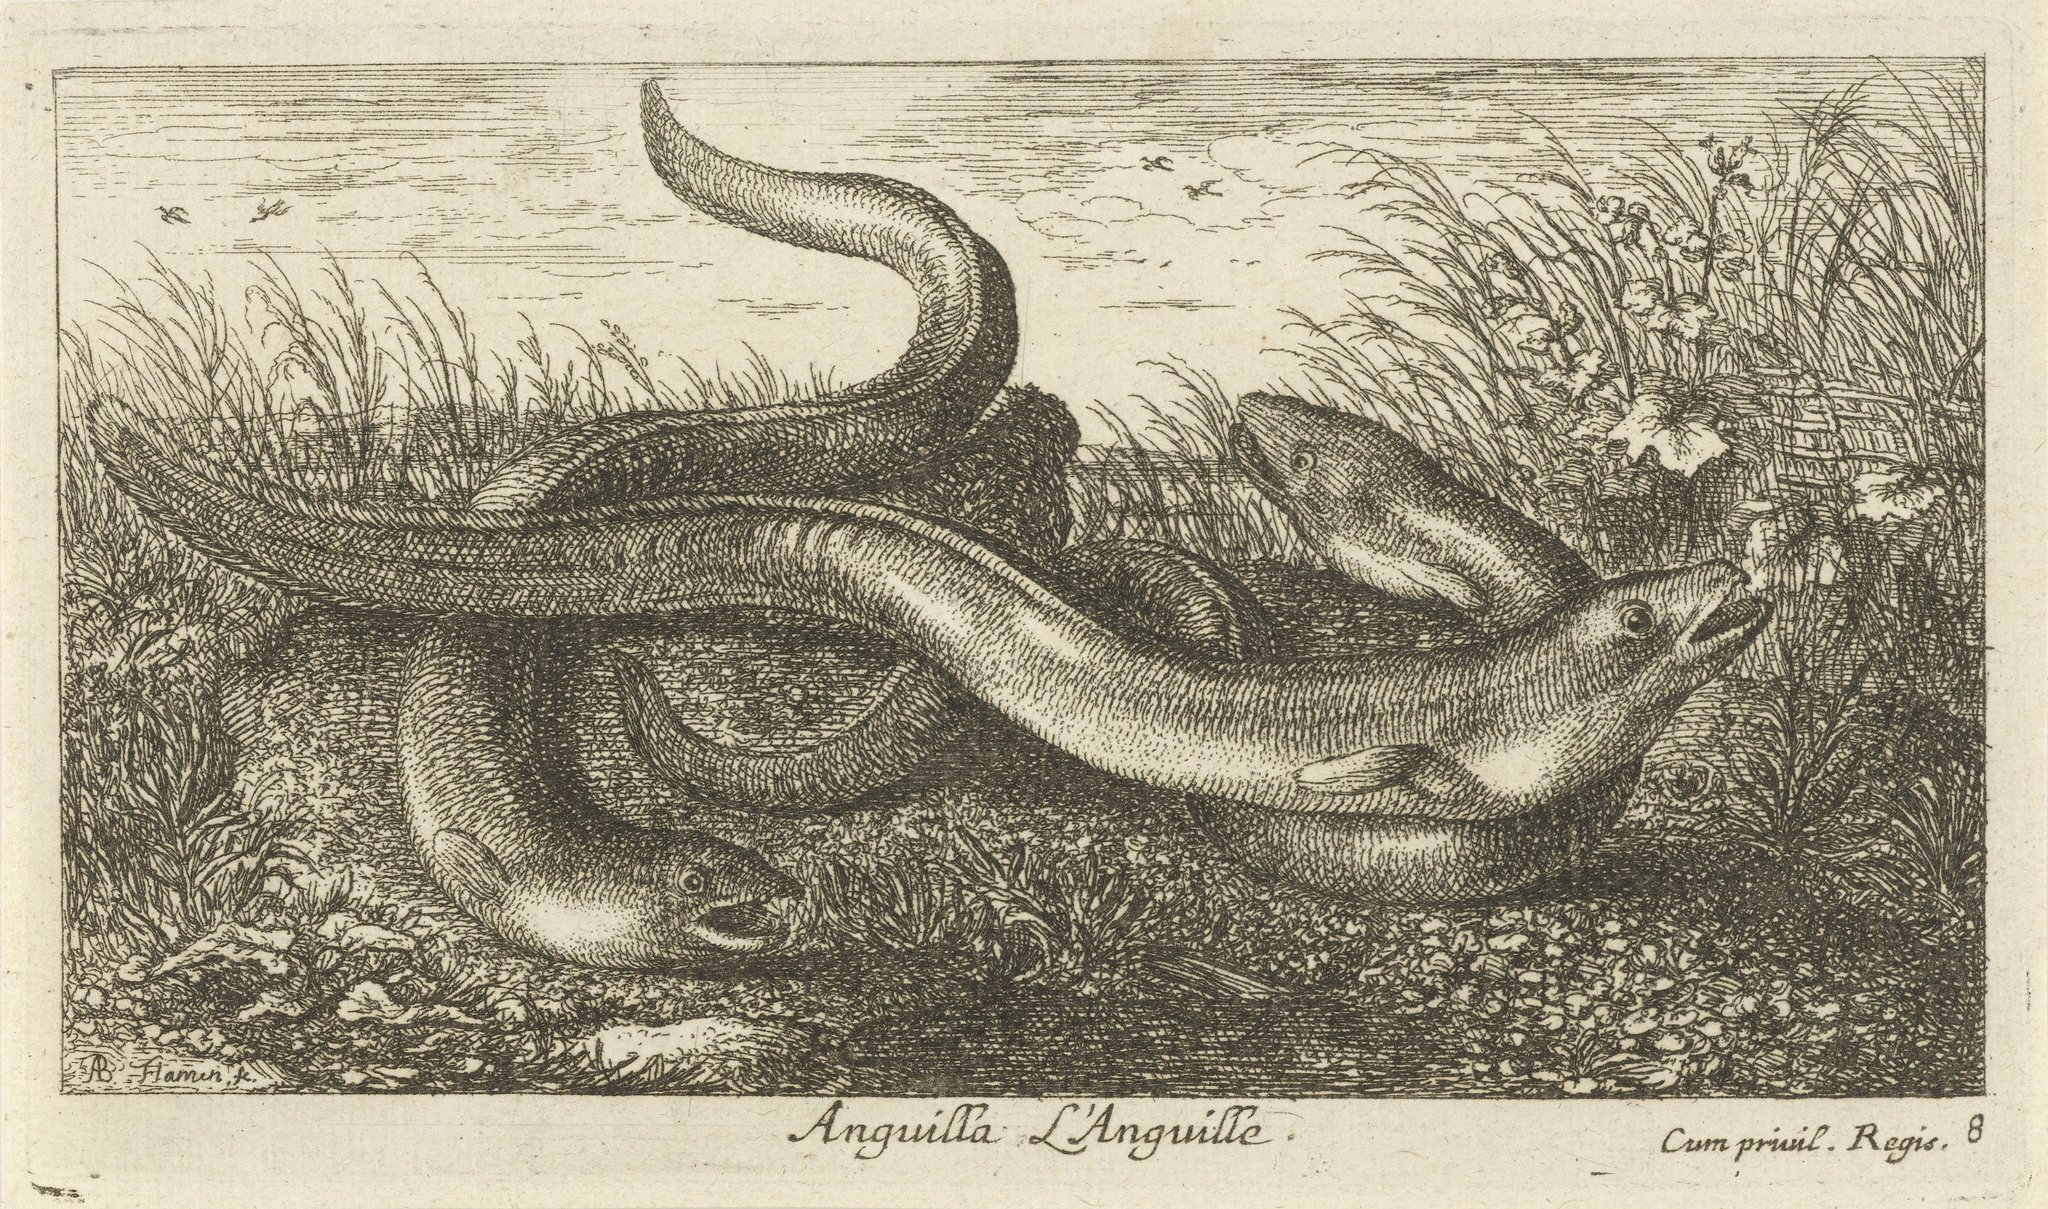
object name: print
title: Drie alen in het gras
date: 1664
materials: paper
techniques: etching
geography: paris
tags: eels: eel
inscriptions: collector's mark: Lugt 2228